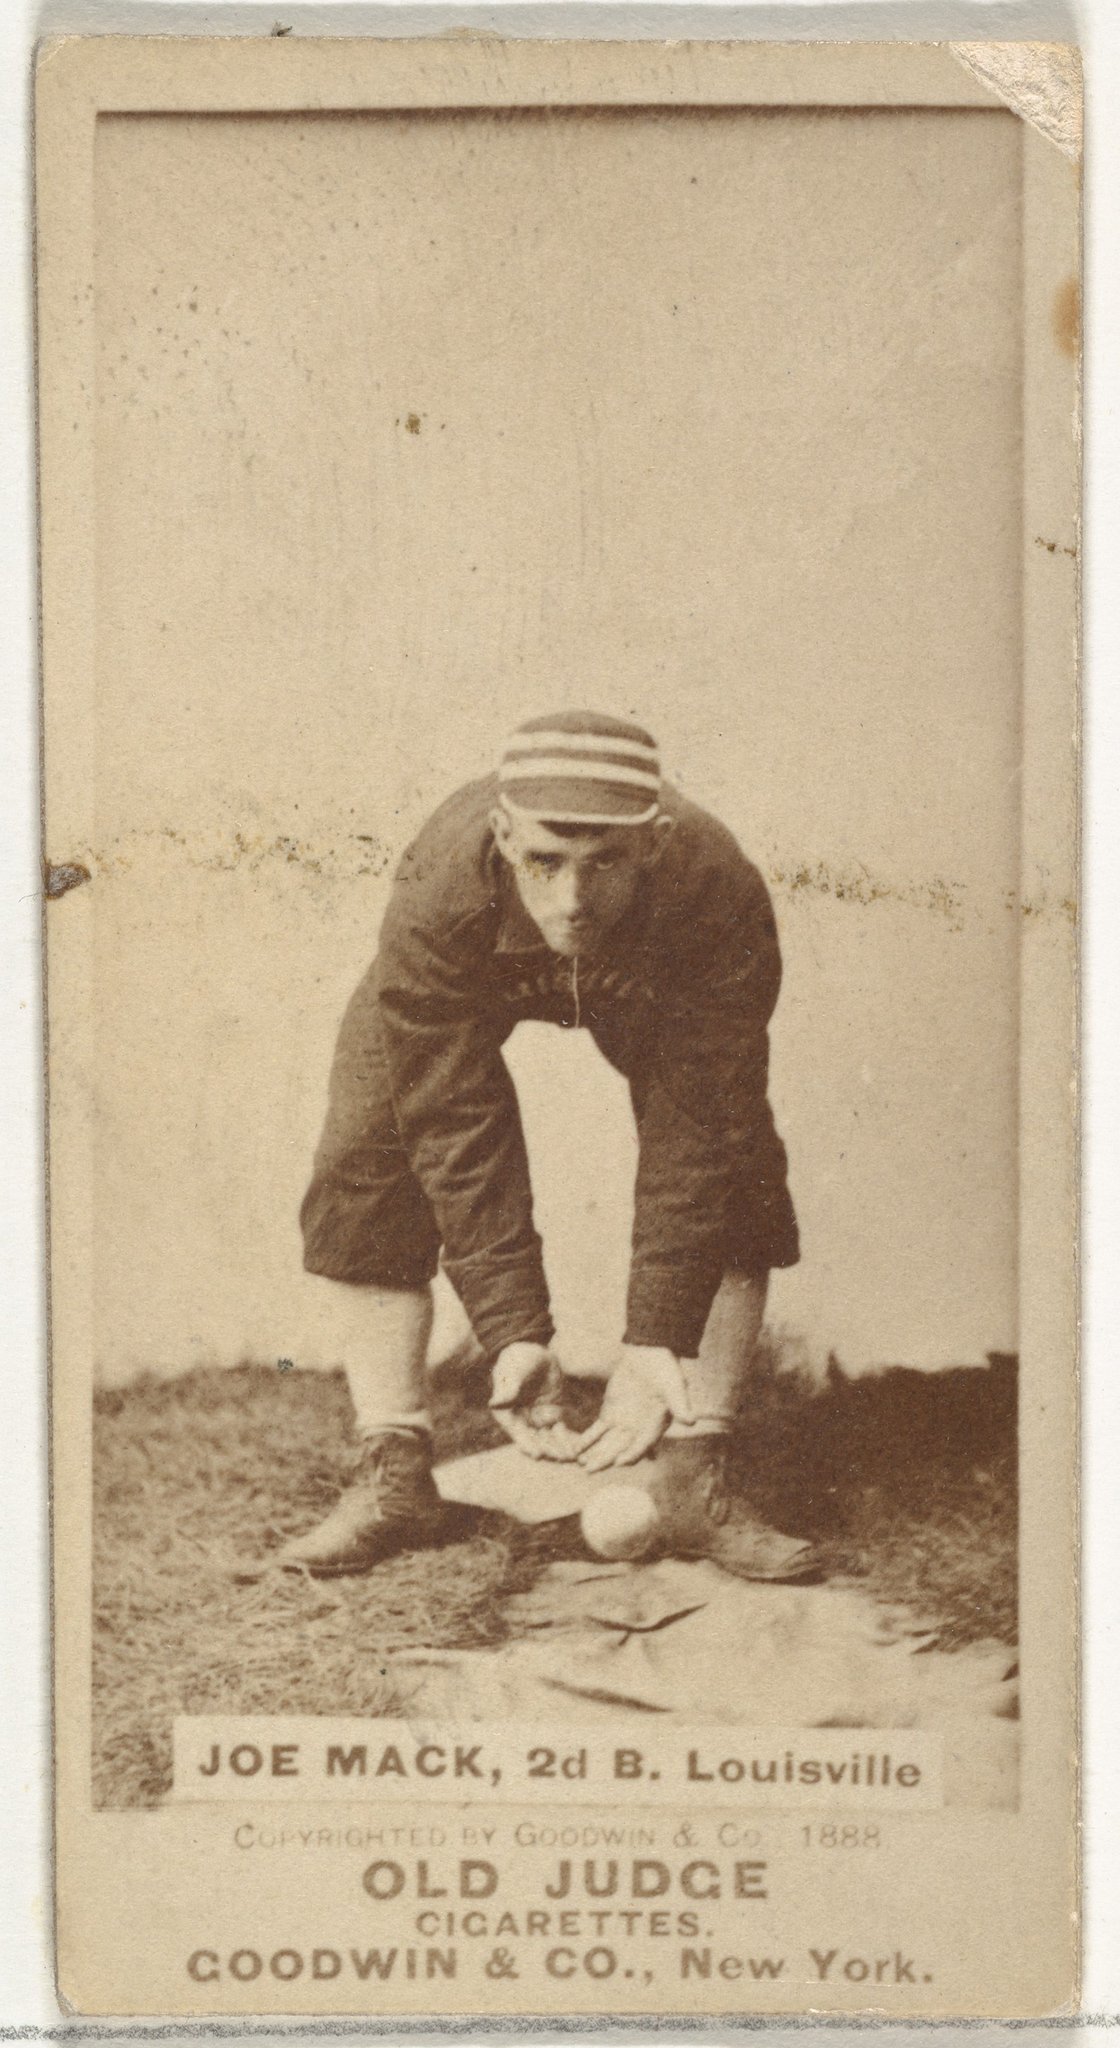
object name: baseball card, photograph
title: Joseph "Reddy" Mack, 2nd Base, Louisville Colonels, from the Old Judge series (N172) for Old Judge Cigarettes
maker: goodwin & company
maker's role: publisher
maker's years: 1850-1950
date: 1888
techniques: albumen silver print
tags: men,portraits,baseball,athletes